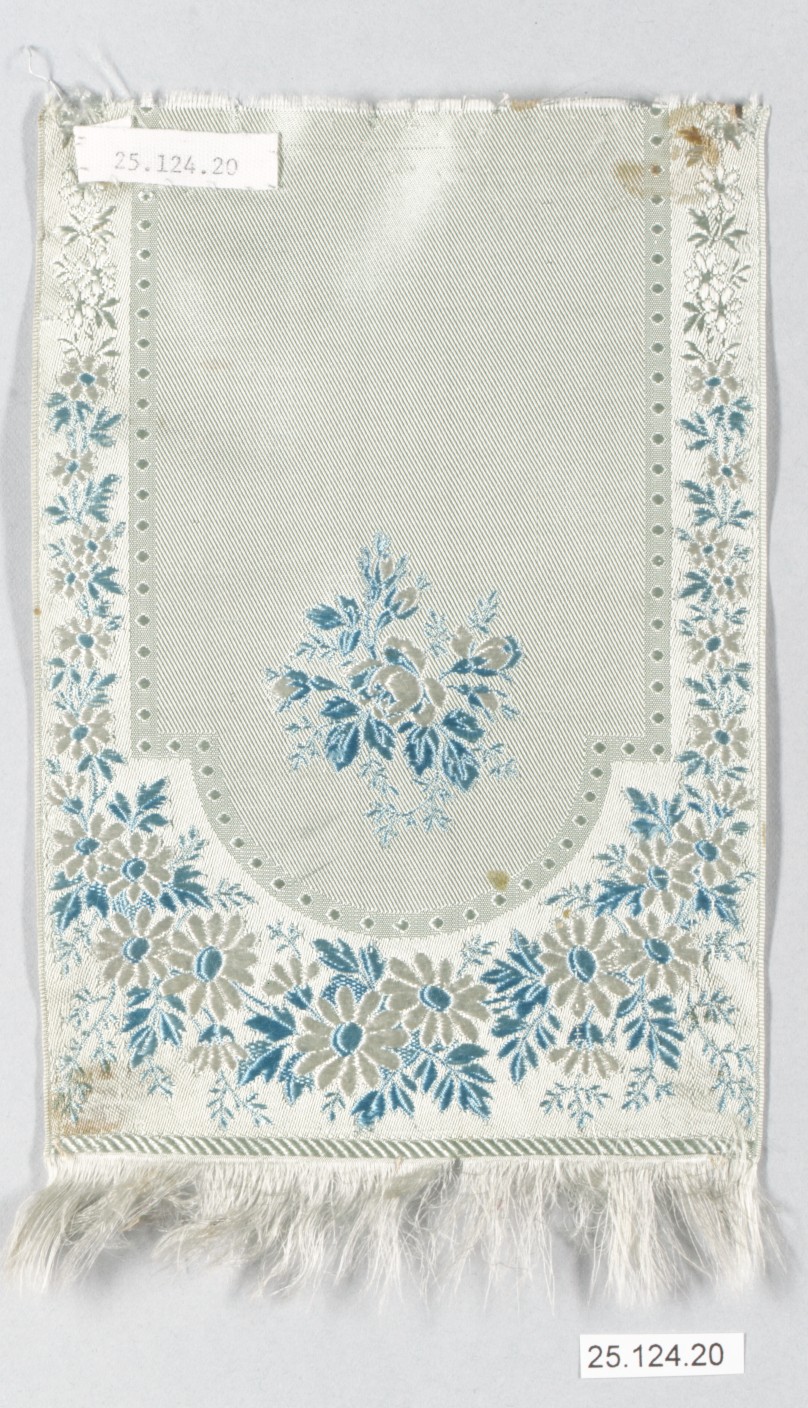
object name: necktie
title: Woman's necktie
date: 1870-1880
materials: silk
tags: flowers